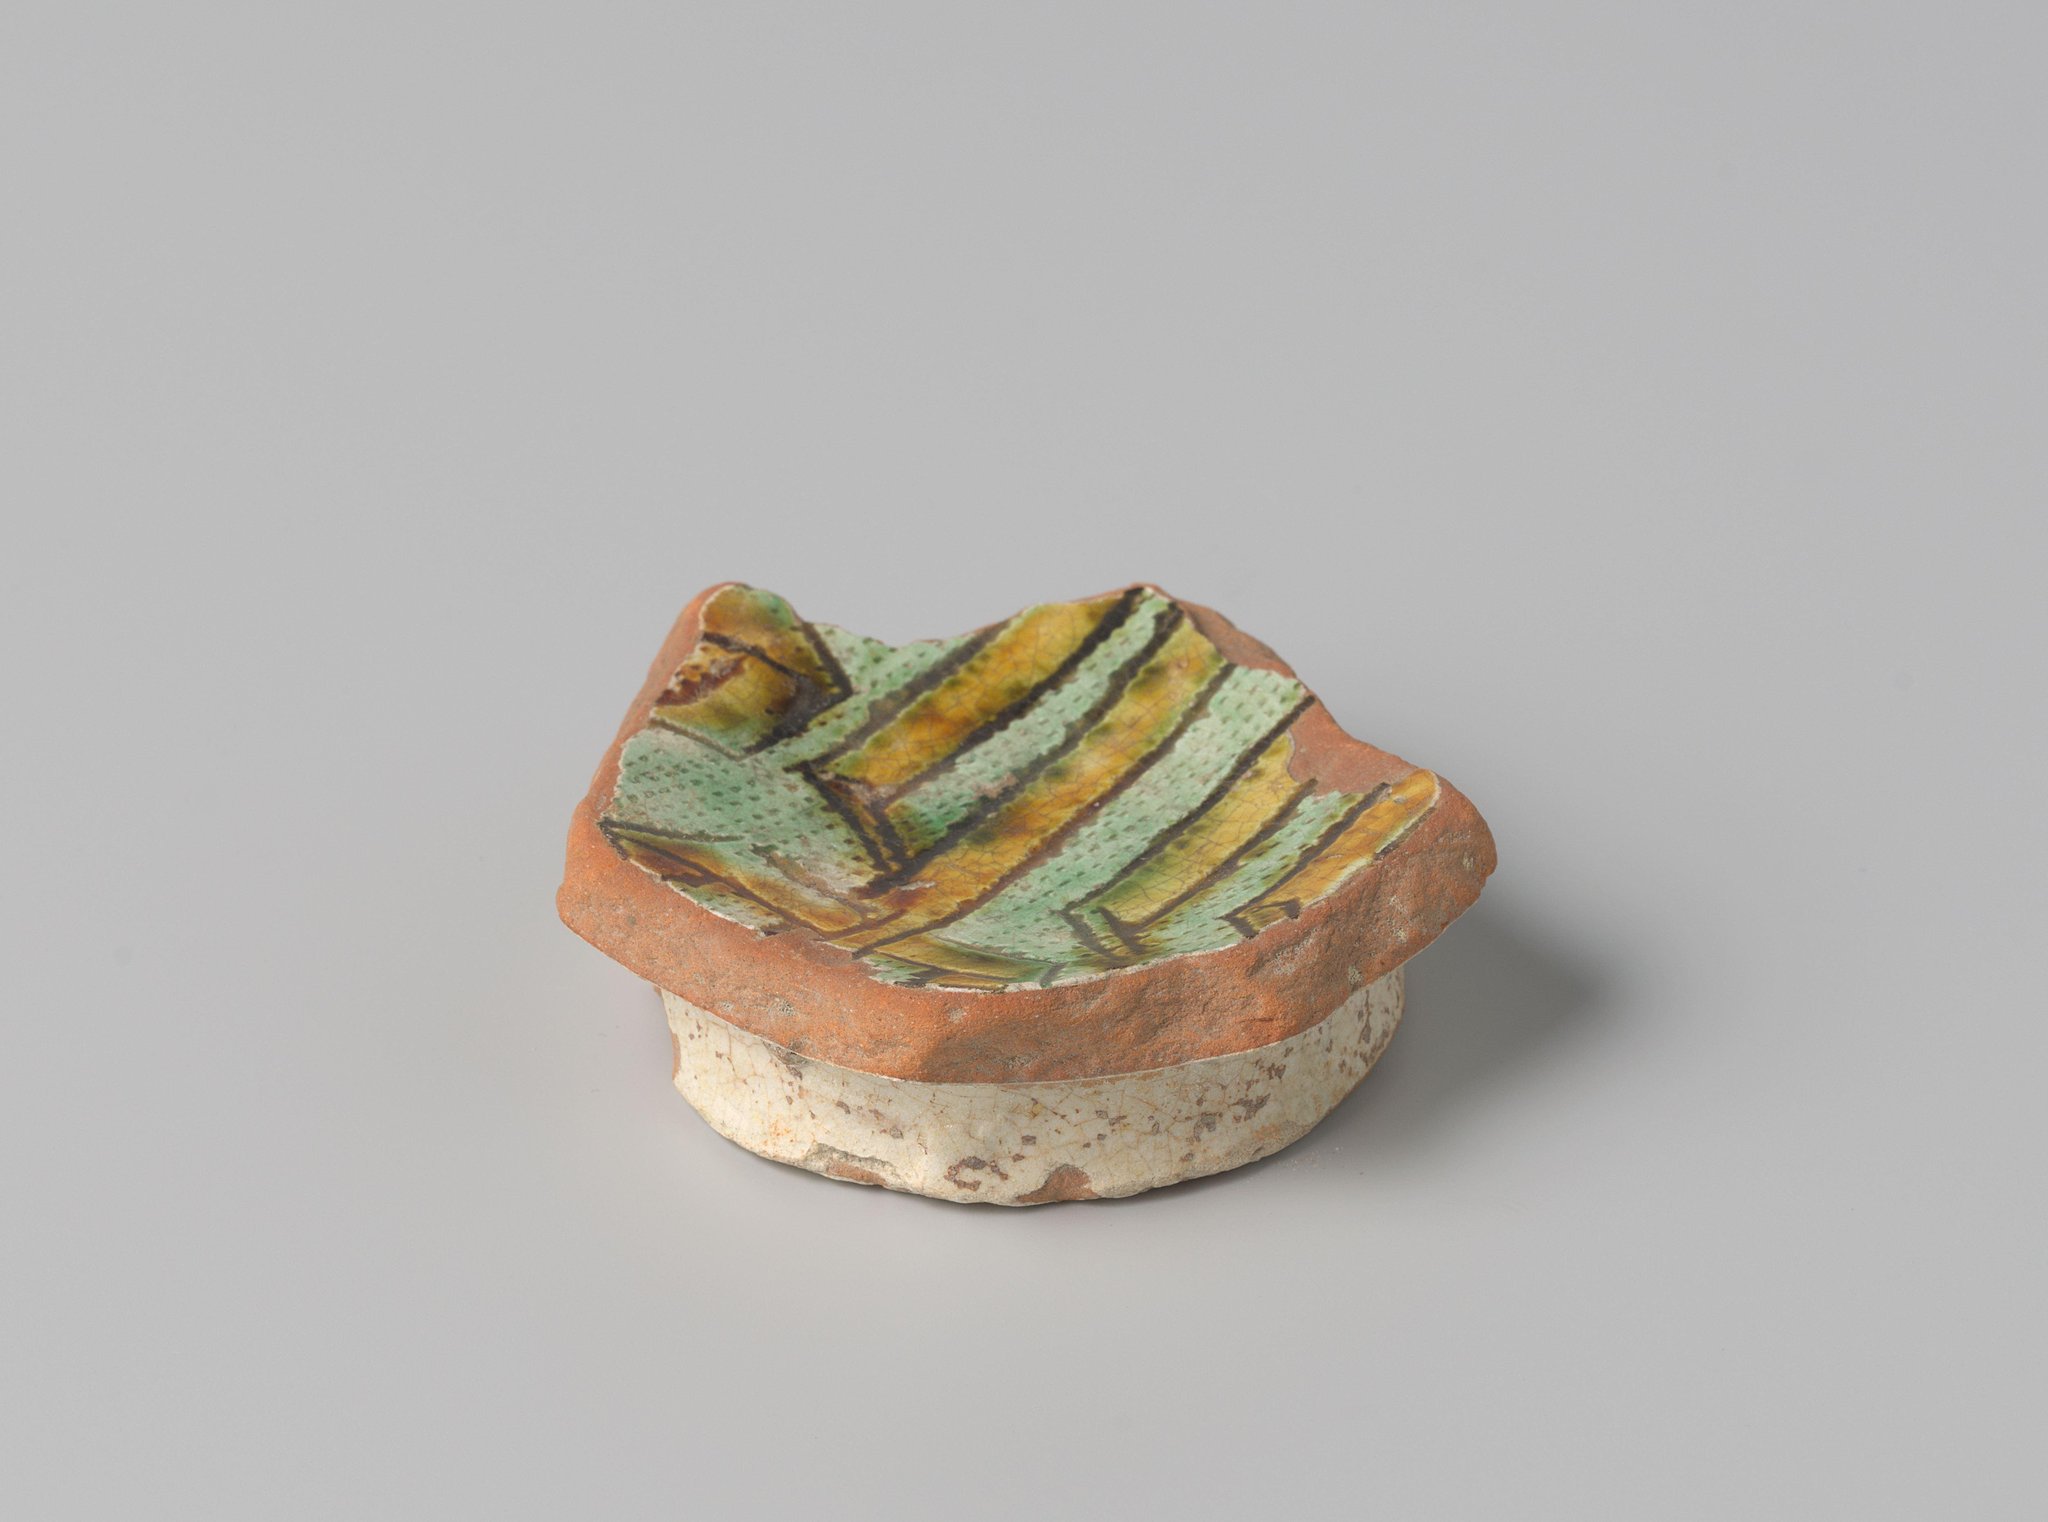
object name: sherd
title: Fragment (voet) met rode scherf, in sgraffito-tekening een kop van een kameel, op de rug waarvan een naakte putto (?) zit, die zich aan zijn hals vasthoudt, op de achtergrond vertikale stippellijnen en restjes van okerkleurig glazuur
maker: Anonymous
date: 1200-1899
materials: earthenware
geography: italy